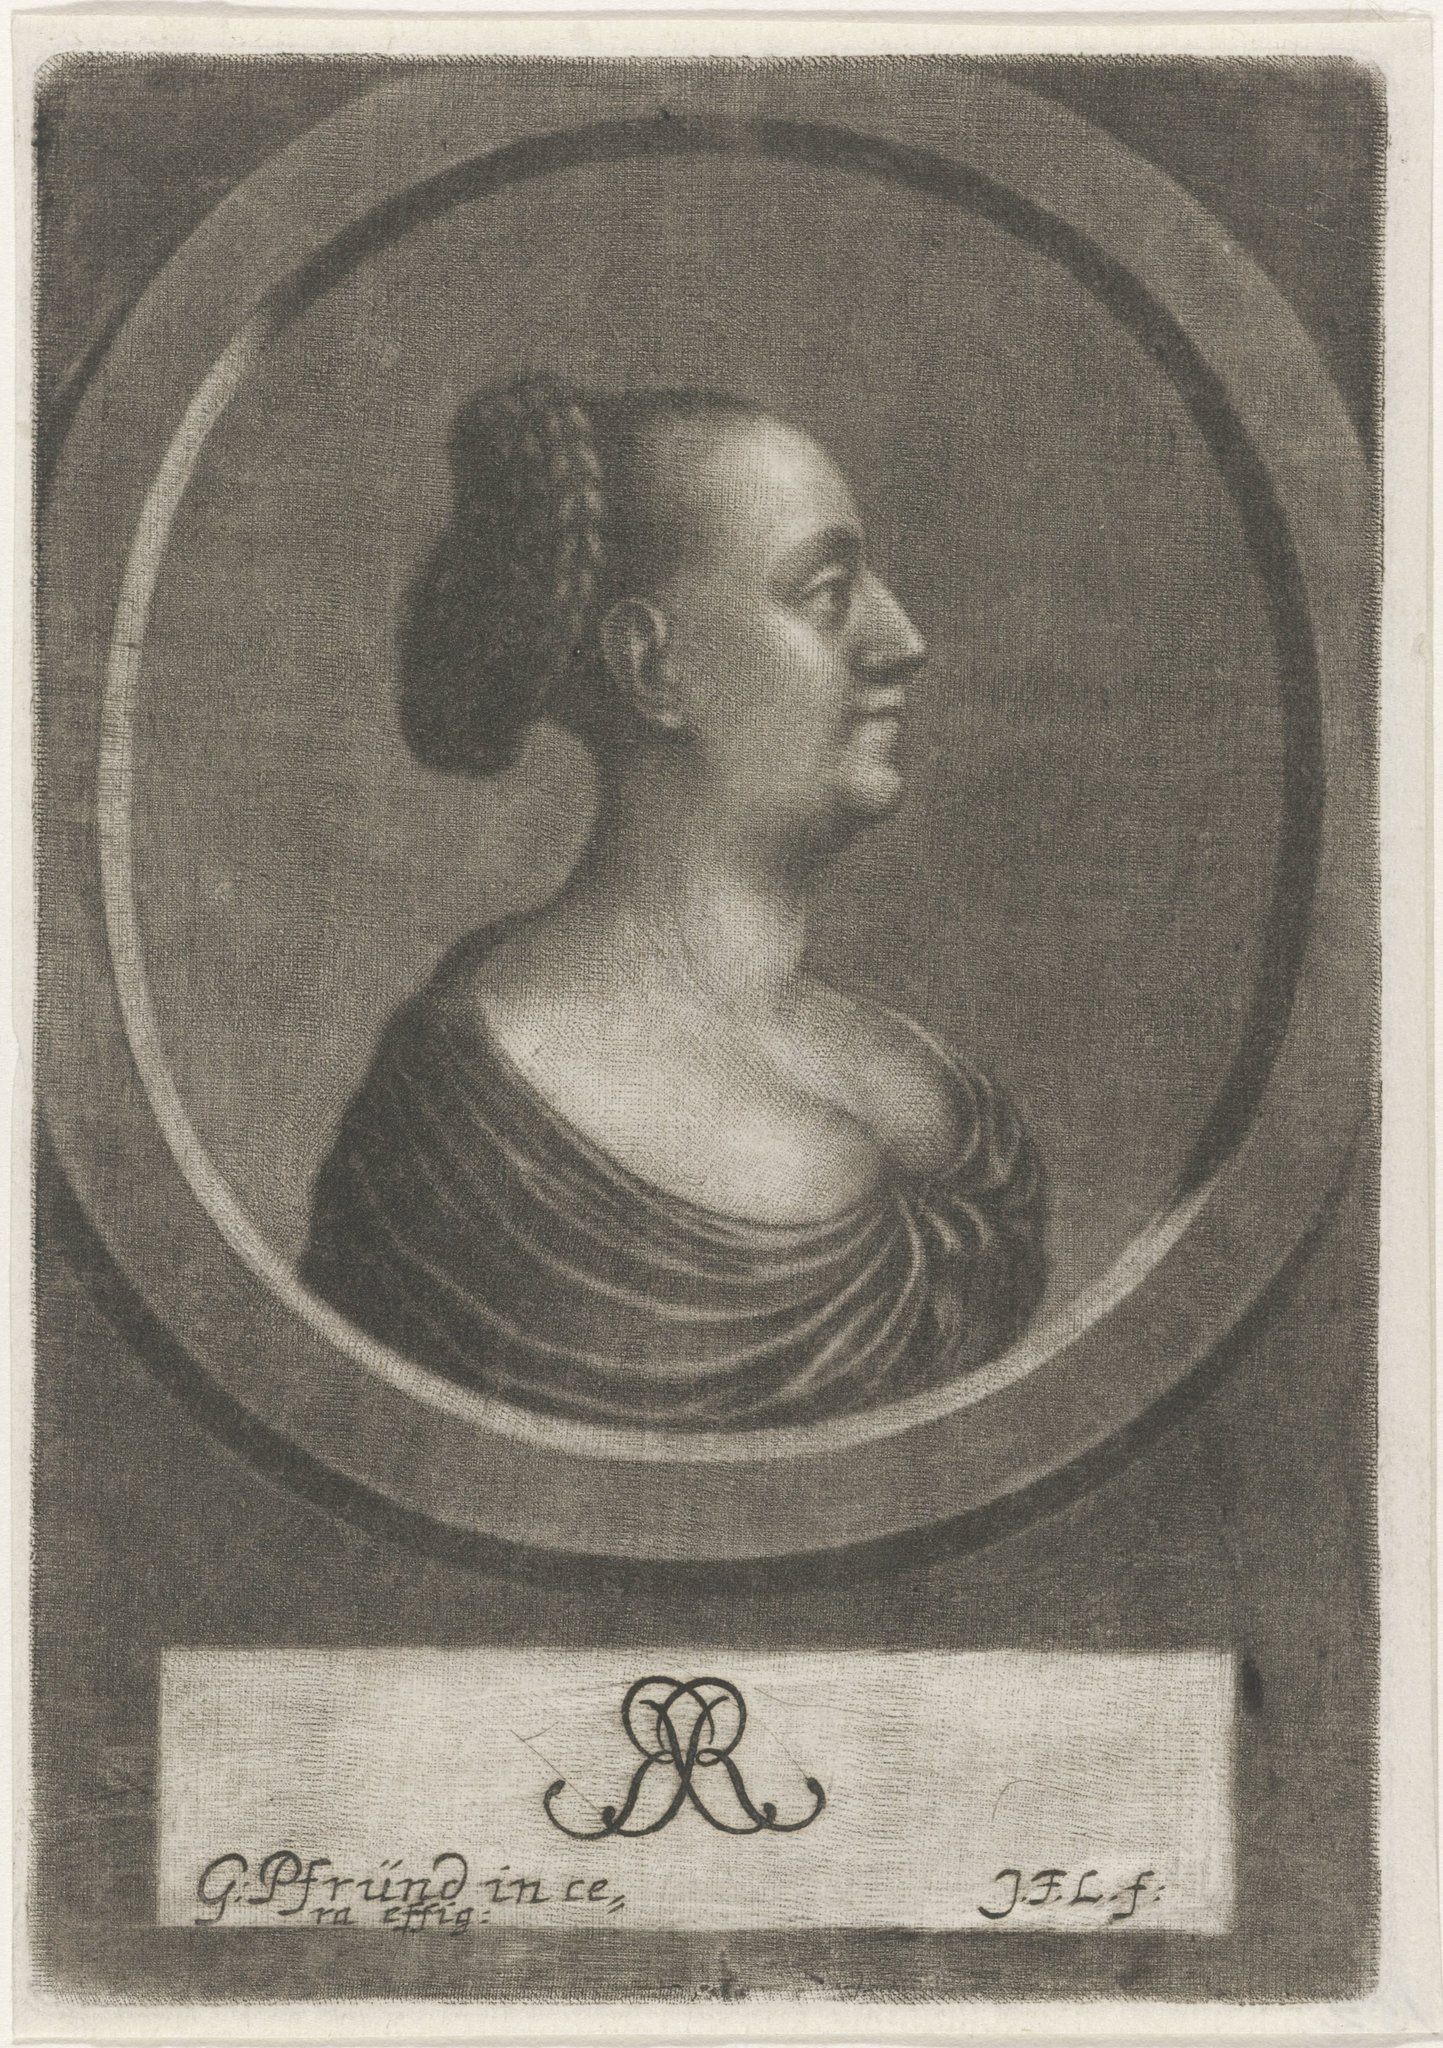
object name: print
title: Portret van Rosina Ritter in profiel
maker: johann friedrich leonard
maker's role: print maker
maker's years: 1633-1680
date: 1643-1680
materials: paper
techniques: engraving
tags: rosina ritter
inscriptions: collector's mark: Lugt 2166